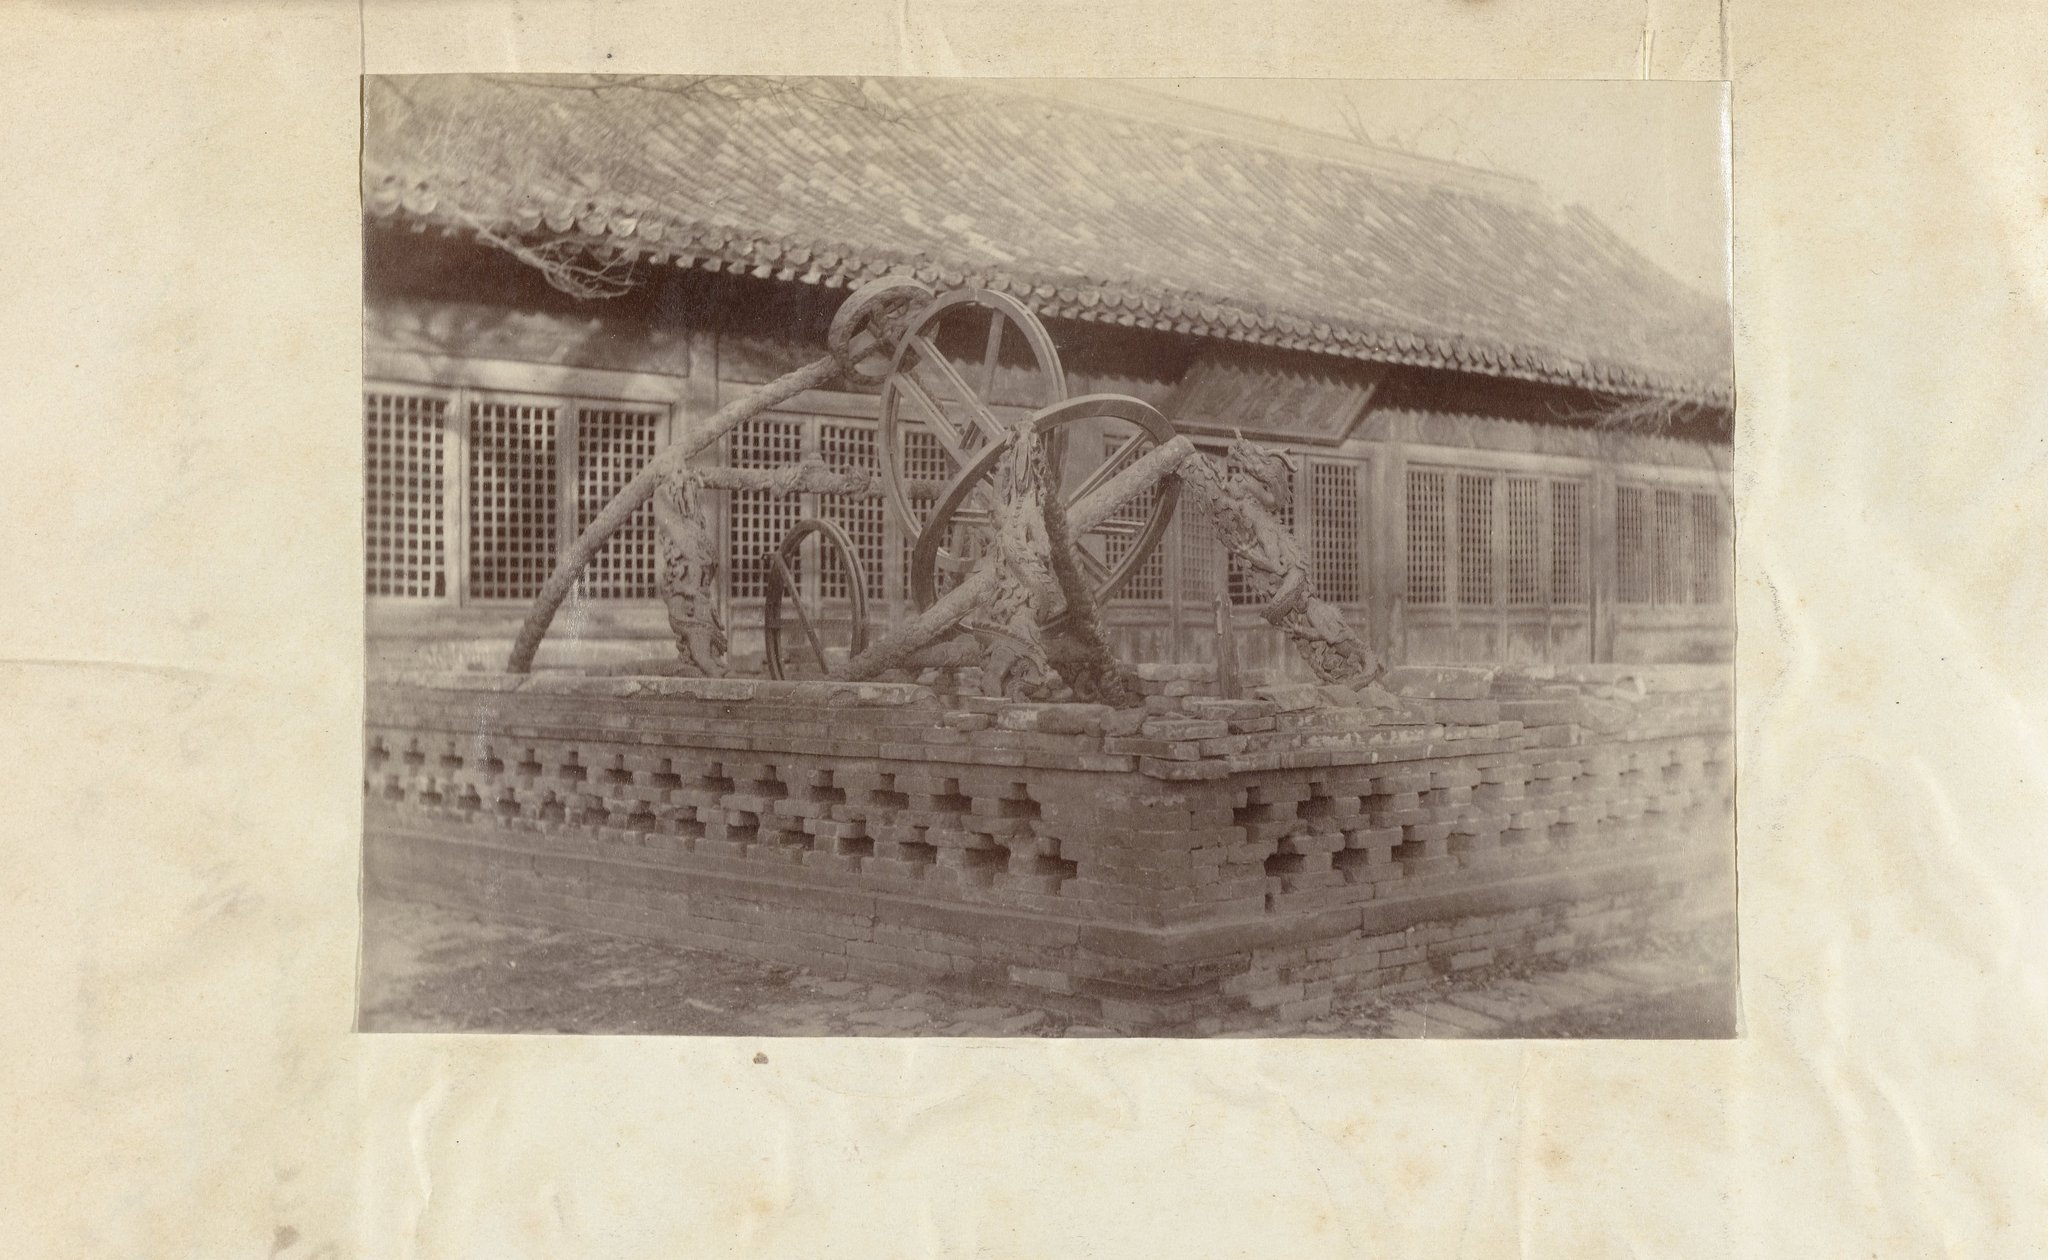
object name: album leaf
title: Astronomische instrumenten bij het oude observatorium van Beijing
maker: Anonymous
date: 1879-1890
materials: paper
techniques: albumen print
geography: beijing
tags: observatory (~ astronomy), astronomical instruments